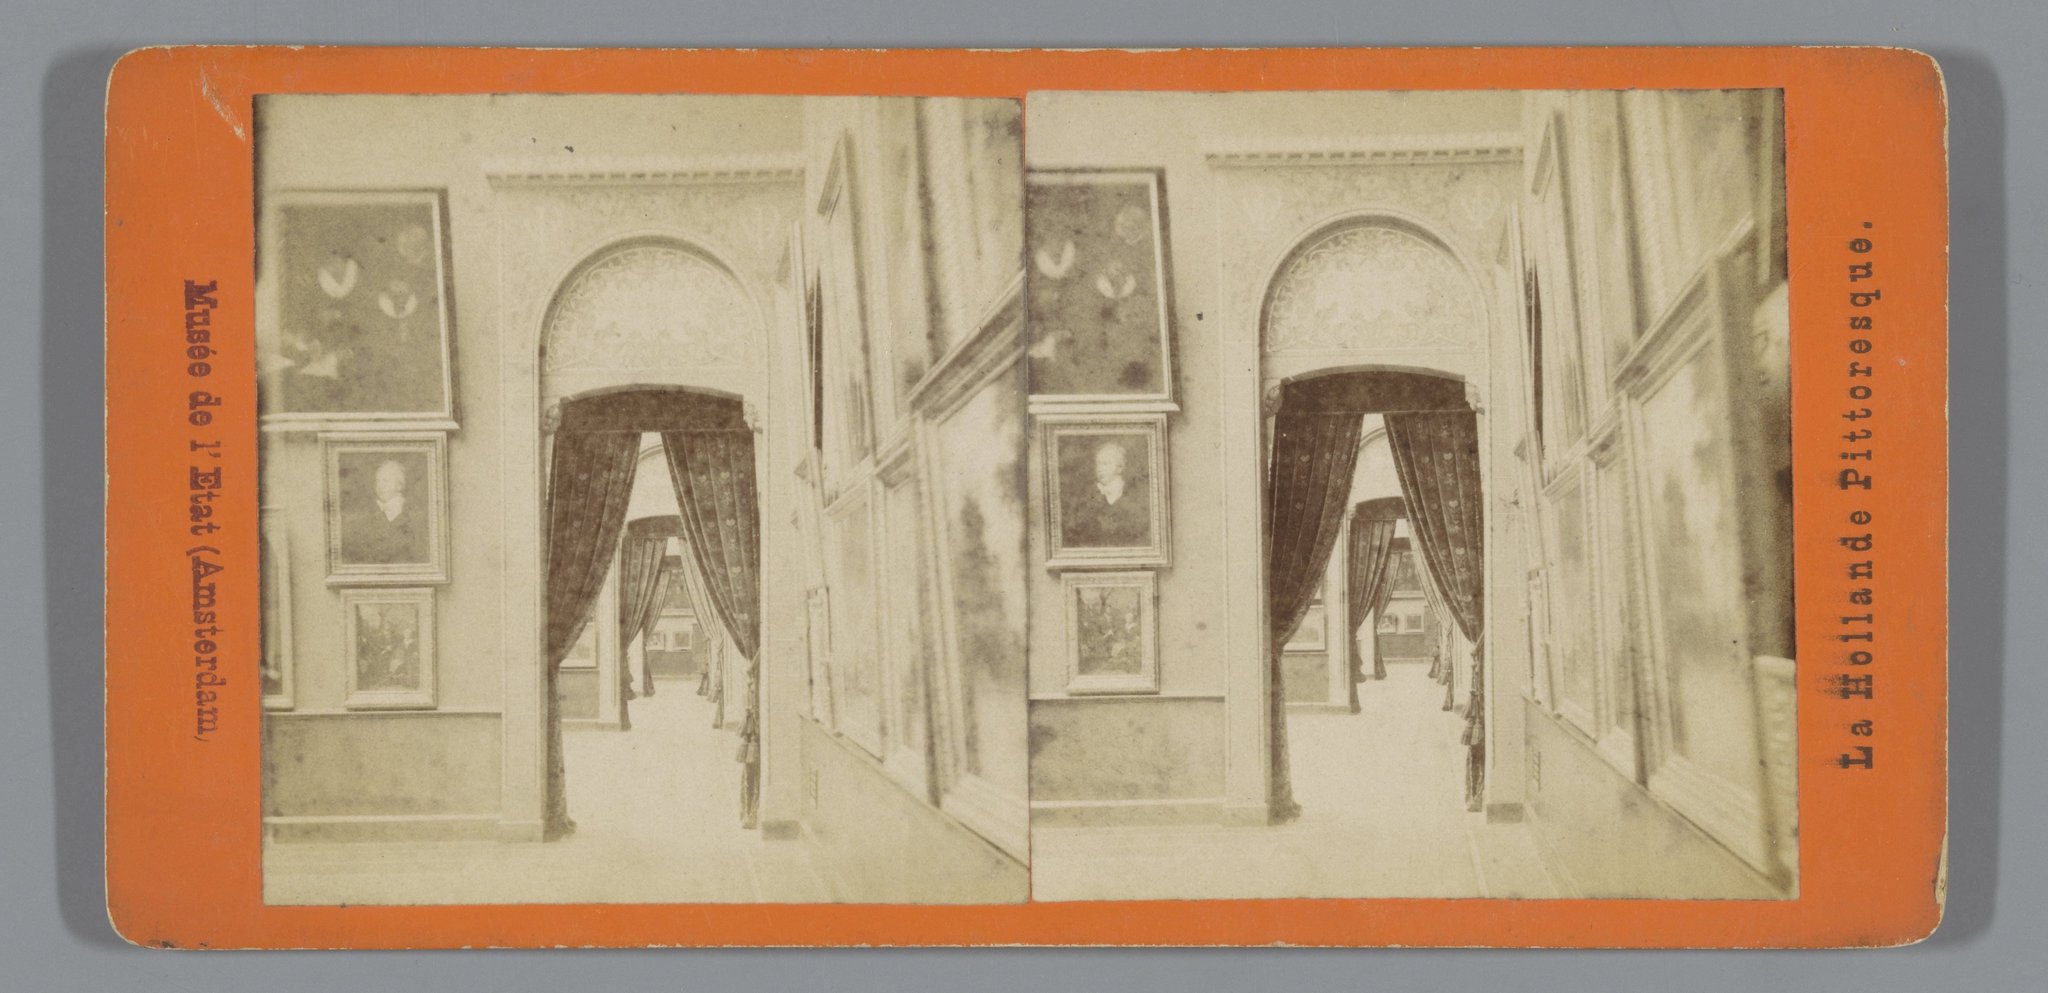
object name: stereograph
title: Zaal 225 van het Rijksmuseum, Amsterdam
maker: andreas theodorus rooswinkel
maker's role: fotograaf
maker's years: 1838-1909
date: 1885-1906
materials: cardboard, paper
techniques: albumen print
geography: amsterdam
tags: collection, exhibition, show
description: Gezicht in de Van de Poll-zaal met schilderijen uit het legaat-Van de Poll, met o.a. het portret van W.F.M. Muilman door Lawrence en Vier regenten en de binnenvader van het leprozenhuis door Van der Valckert. Doorzicht naar de zalen 226, 227 en 228.